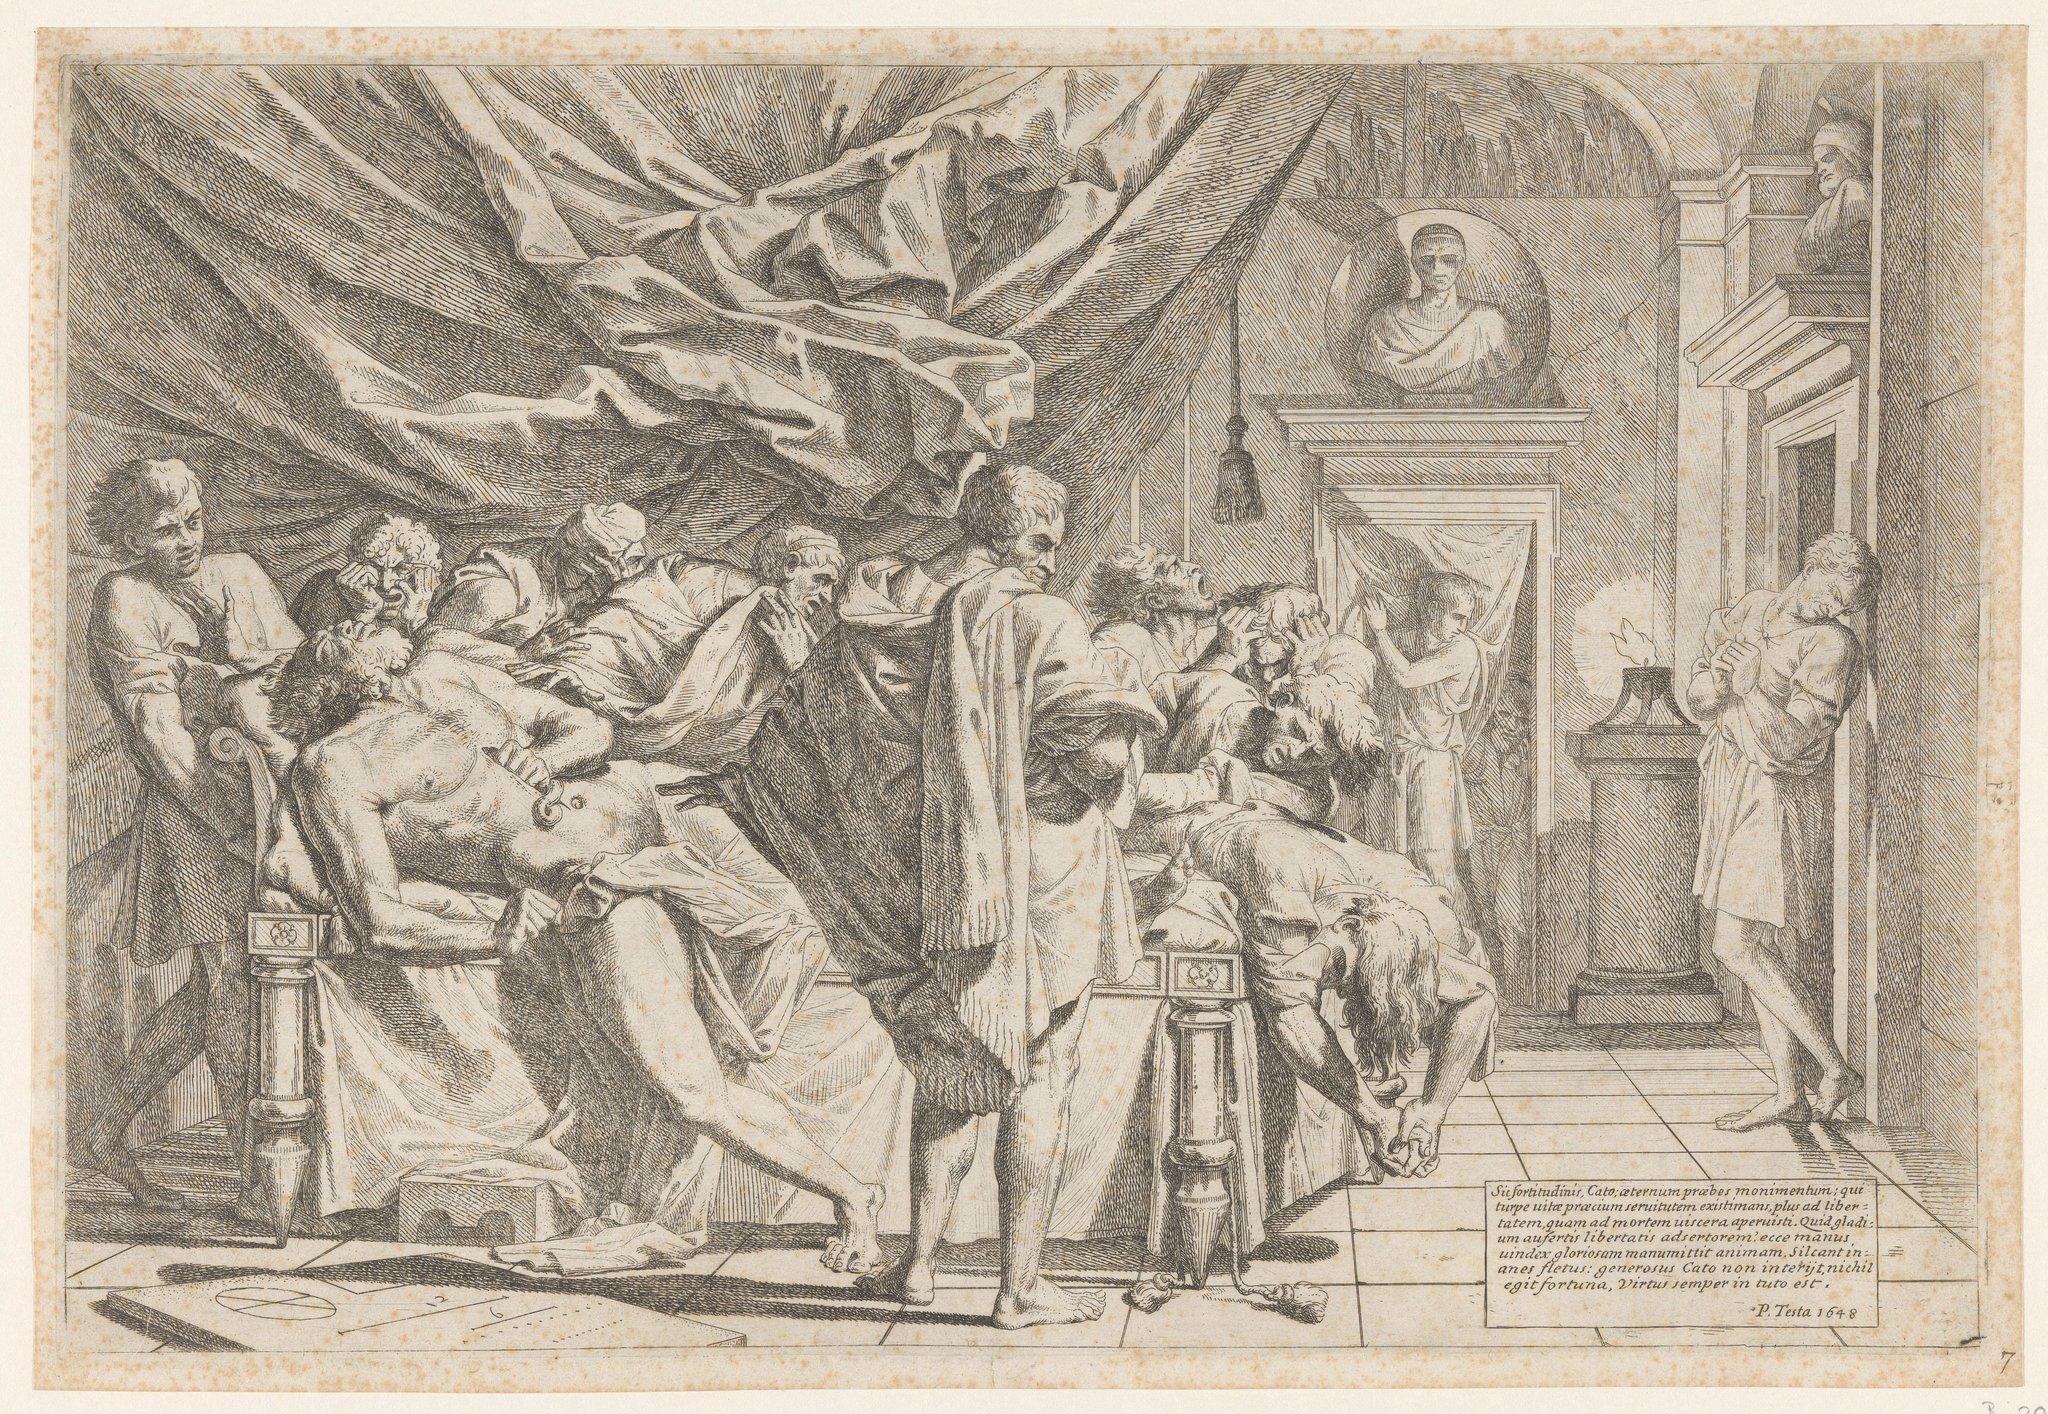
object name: print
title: Dood van Cato, 46 v.Chr.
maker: pietro testa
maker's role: draughtsman, painter, print maker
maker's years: 1611-1650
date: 1648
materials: paper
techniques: etching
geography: italy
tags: politician, death of marcus porcius cato the younger surnamed uticensis: he stabs himself on his couch, after reading plato's phaedo; he may be seen tearing out his entrails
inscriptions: number: ‘F 32’, number: ‘7’, collector's mark: Lugt 11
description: In zijn slaapvertrek heeft de staatsman Cato zichzelf doorstoken. Liggend op een bed trekt hij ingewanden uit zijn lichaam. Een groep omstanders kijkt verafschuwd toe. Zeven regels Latijnse tekst in cartouche rechtsonder. 46 v.Chr.